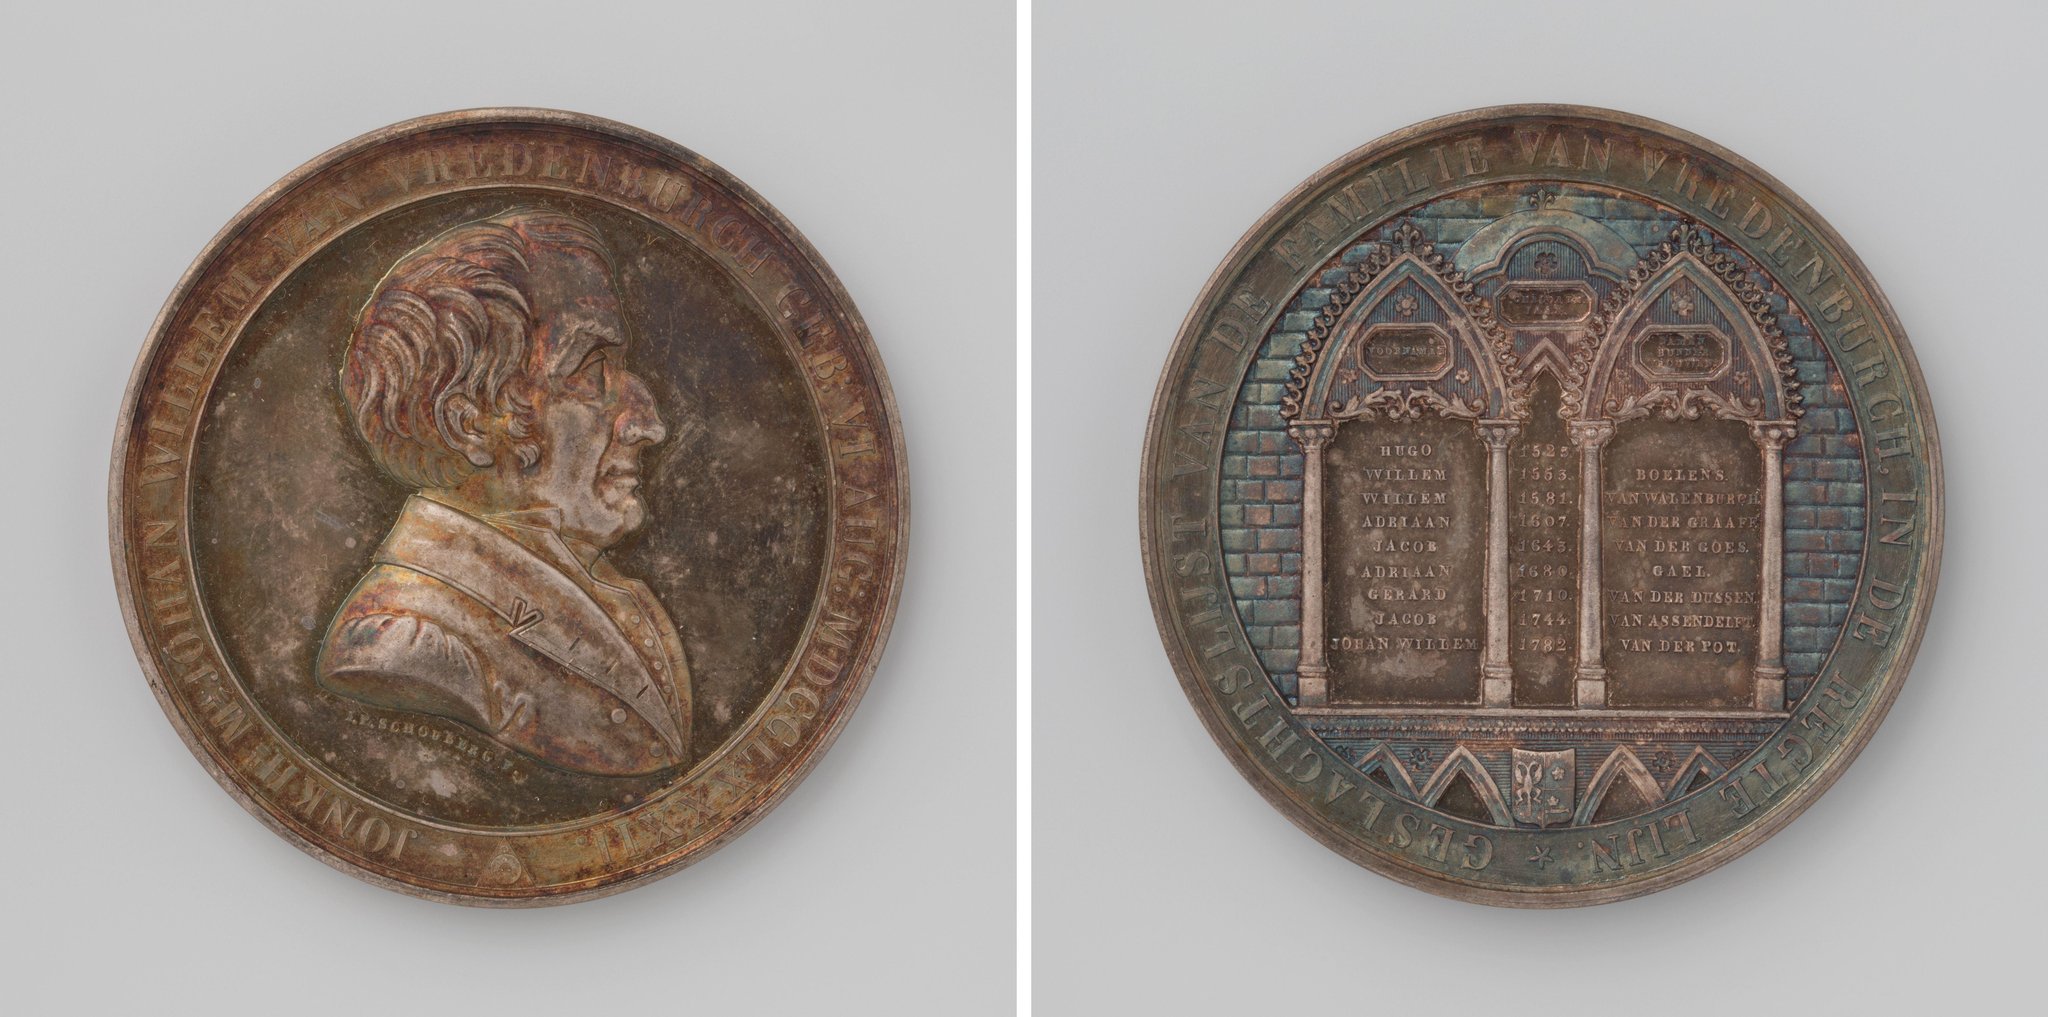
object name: history medal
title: Jonkheer Johan Willem van Vredenburch, ter ere van zijn voorouders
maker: johannis petrus schouberg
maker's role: die cutter, draughtsman, print maker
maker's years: 1798-1864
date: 1842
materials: silver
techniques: striking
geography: utrecht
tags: jonkheer johan willem van vredenburch van groeneveld, delft